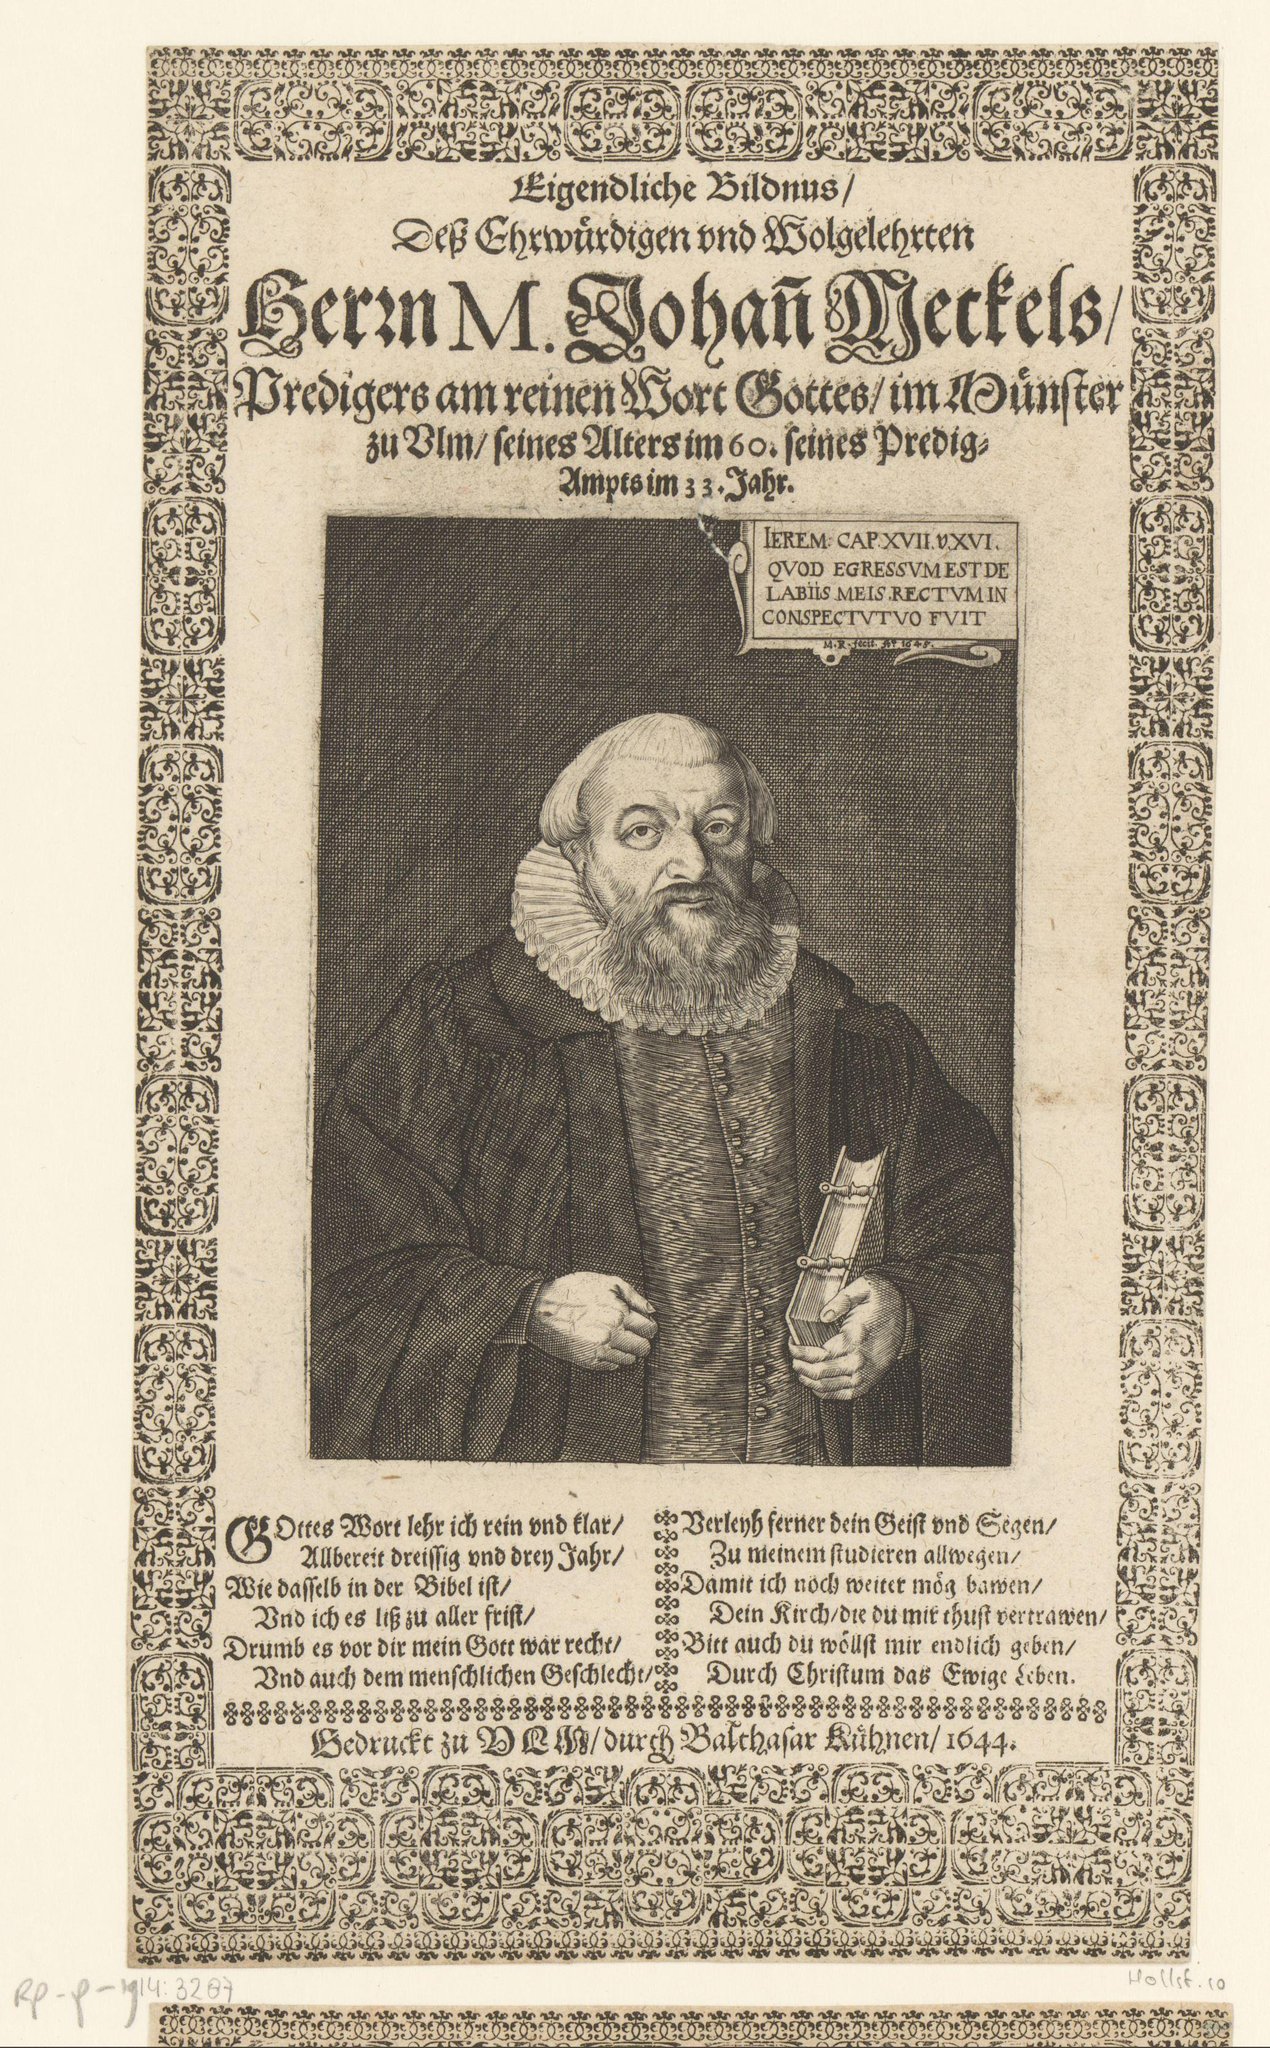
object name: print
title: Portret van Johann Meckel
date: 1645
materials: paper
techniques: engraving, letterpress printing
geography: ulm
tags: historical persons, book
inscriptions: collector's mark: Lugt 2228